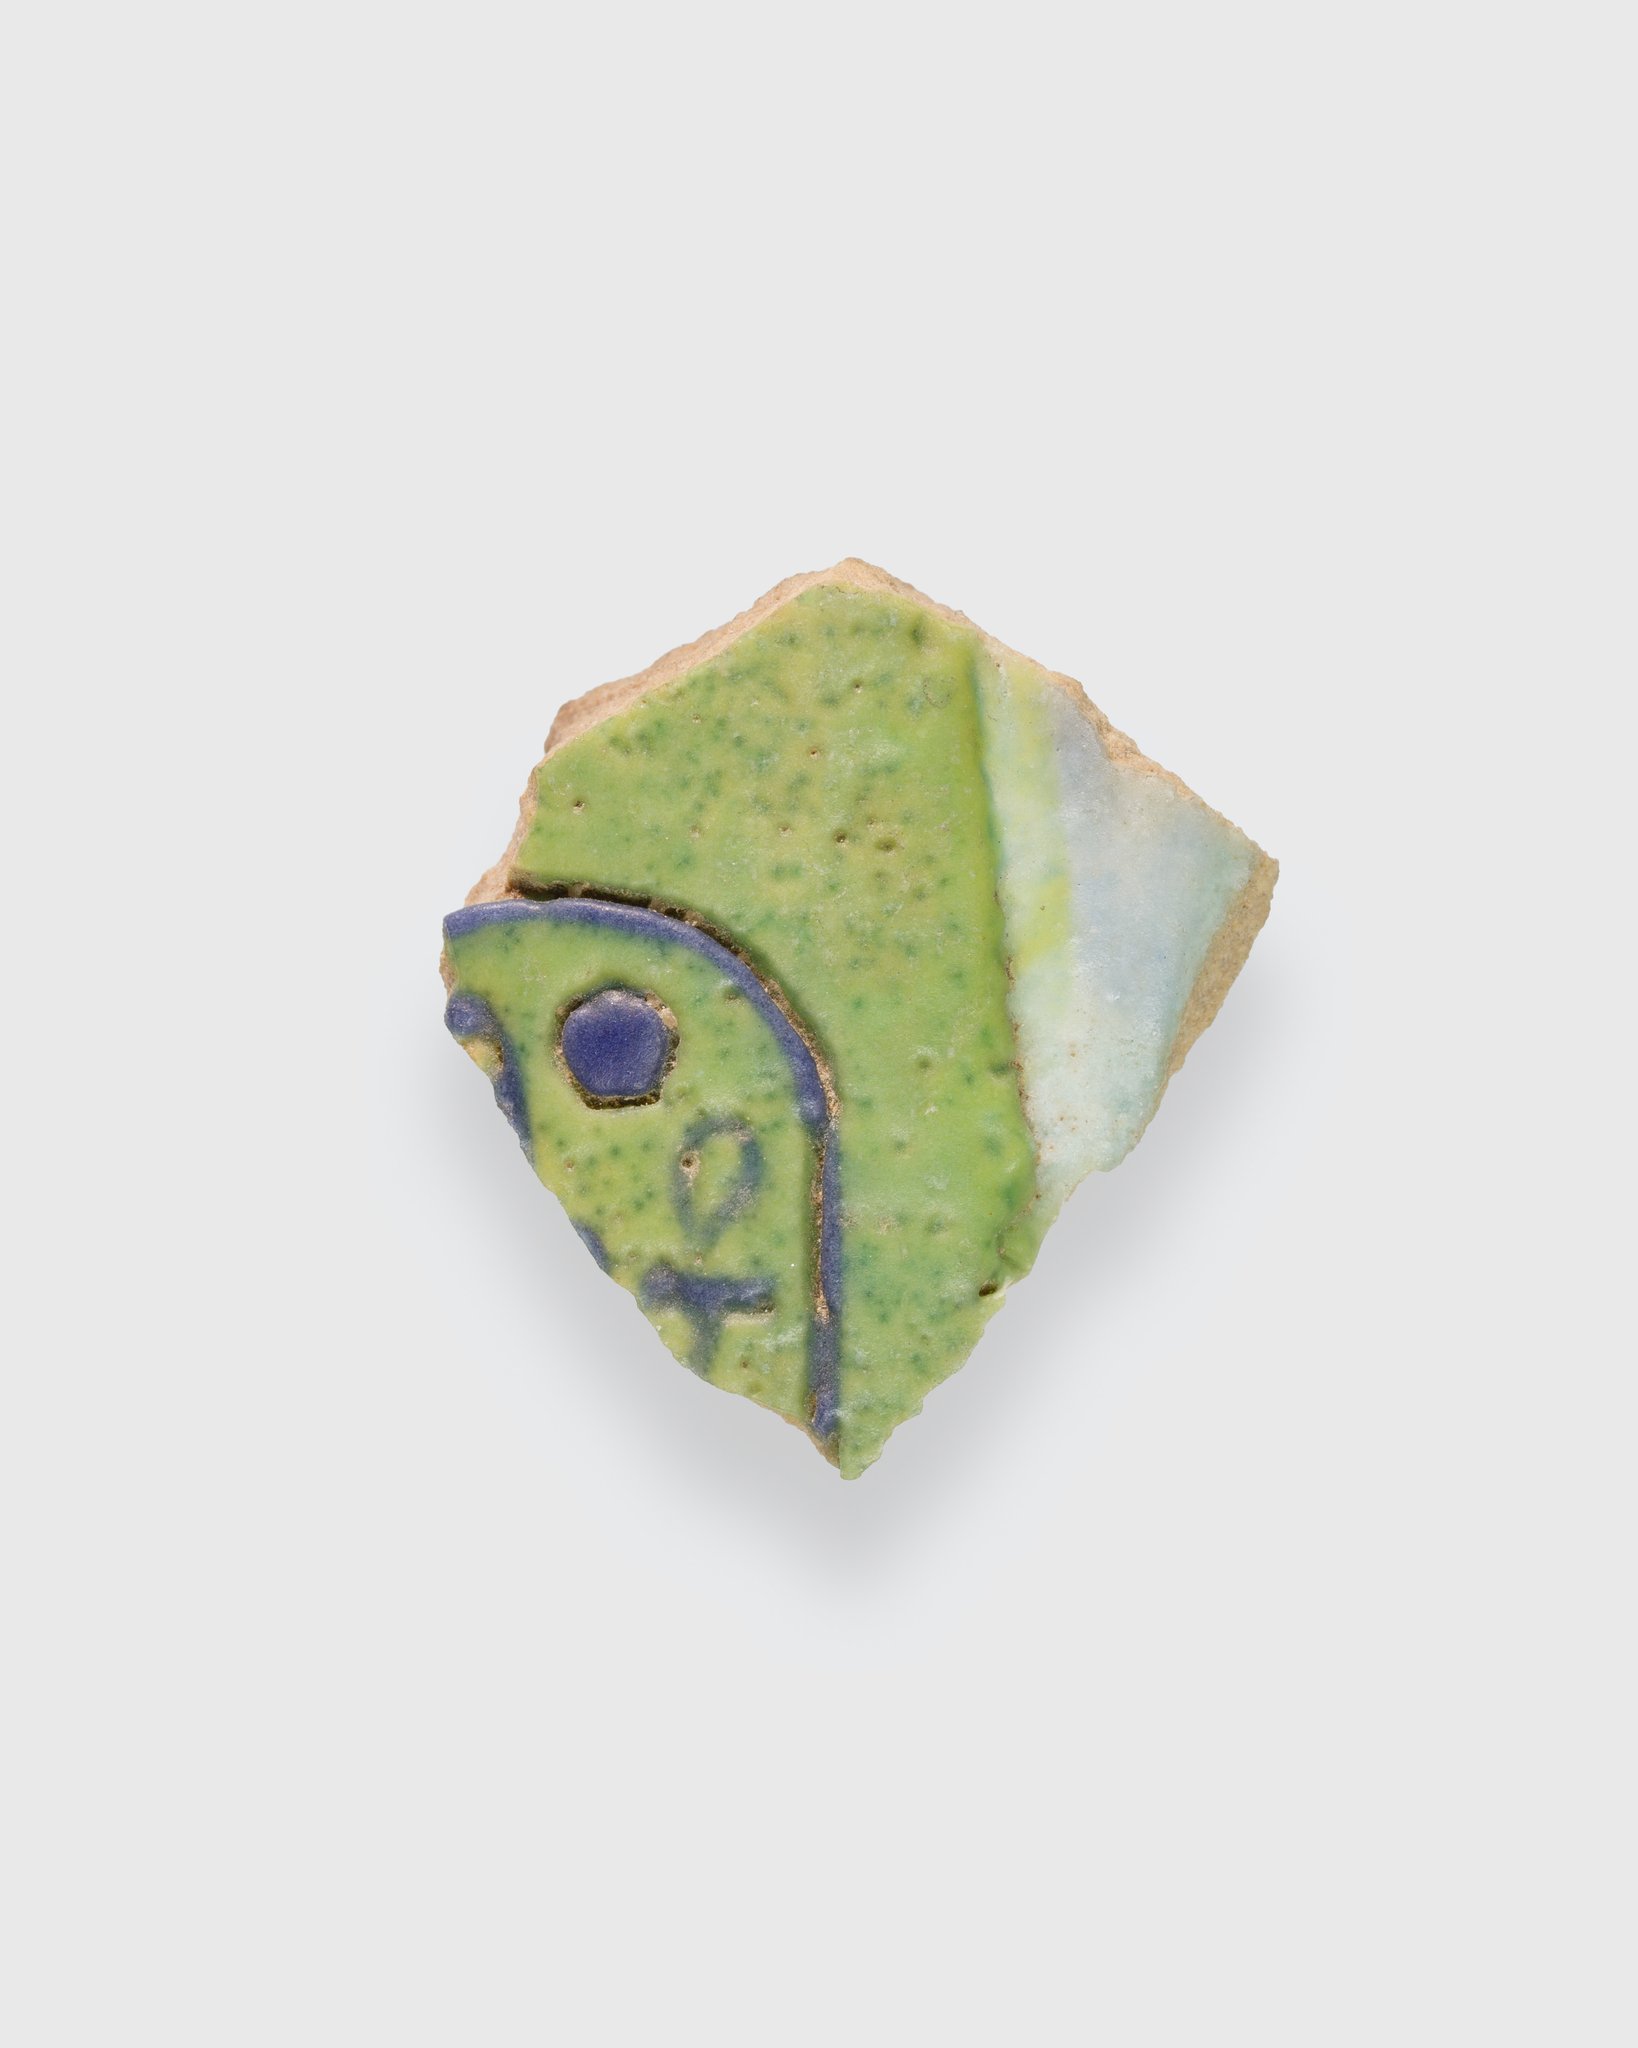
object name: inlay, lotus, bud fragment, amenhotep iii, nebmaatre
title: Fragments of Architectural Lotus Ornament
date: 1390-1352 BCE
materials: faience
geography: egypt